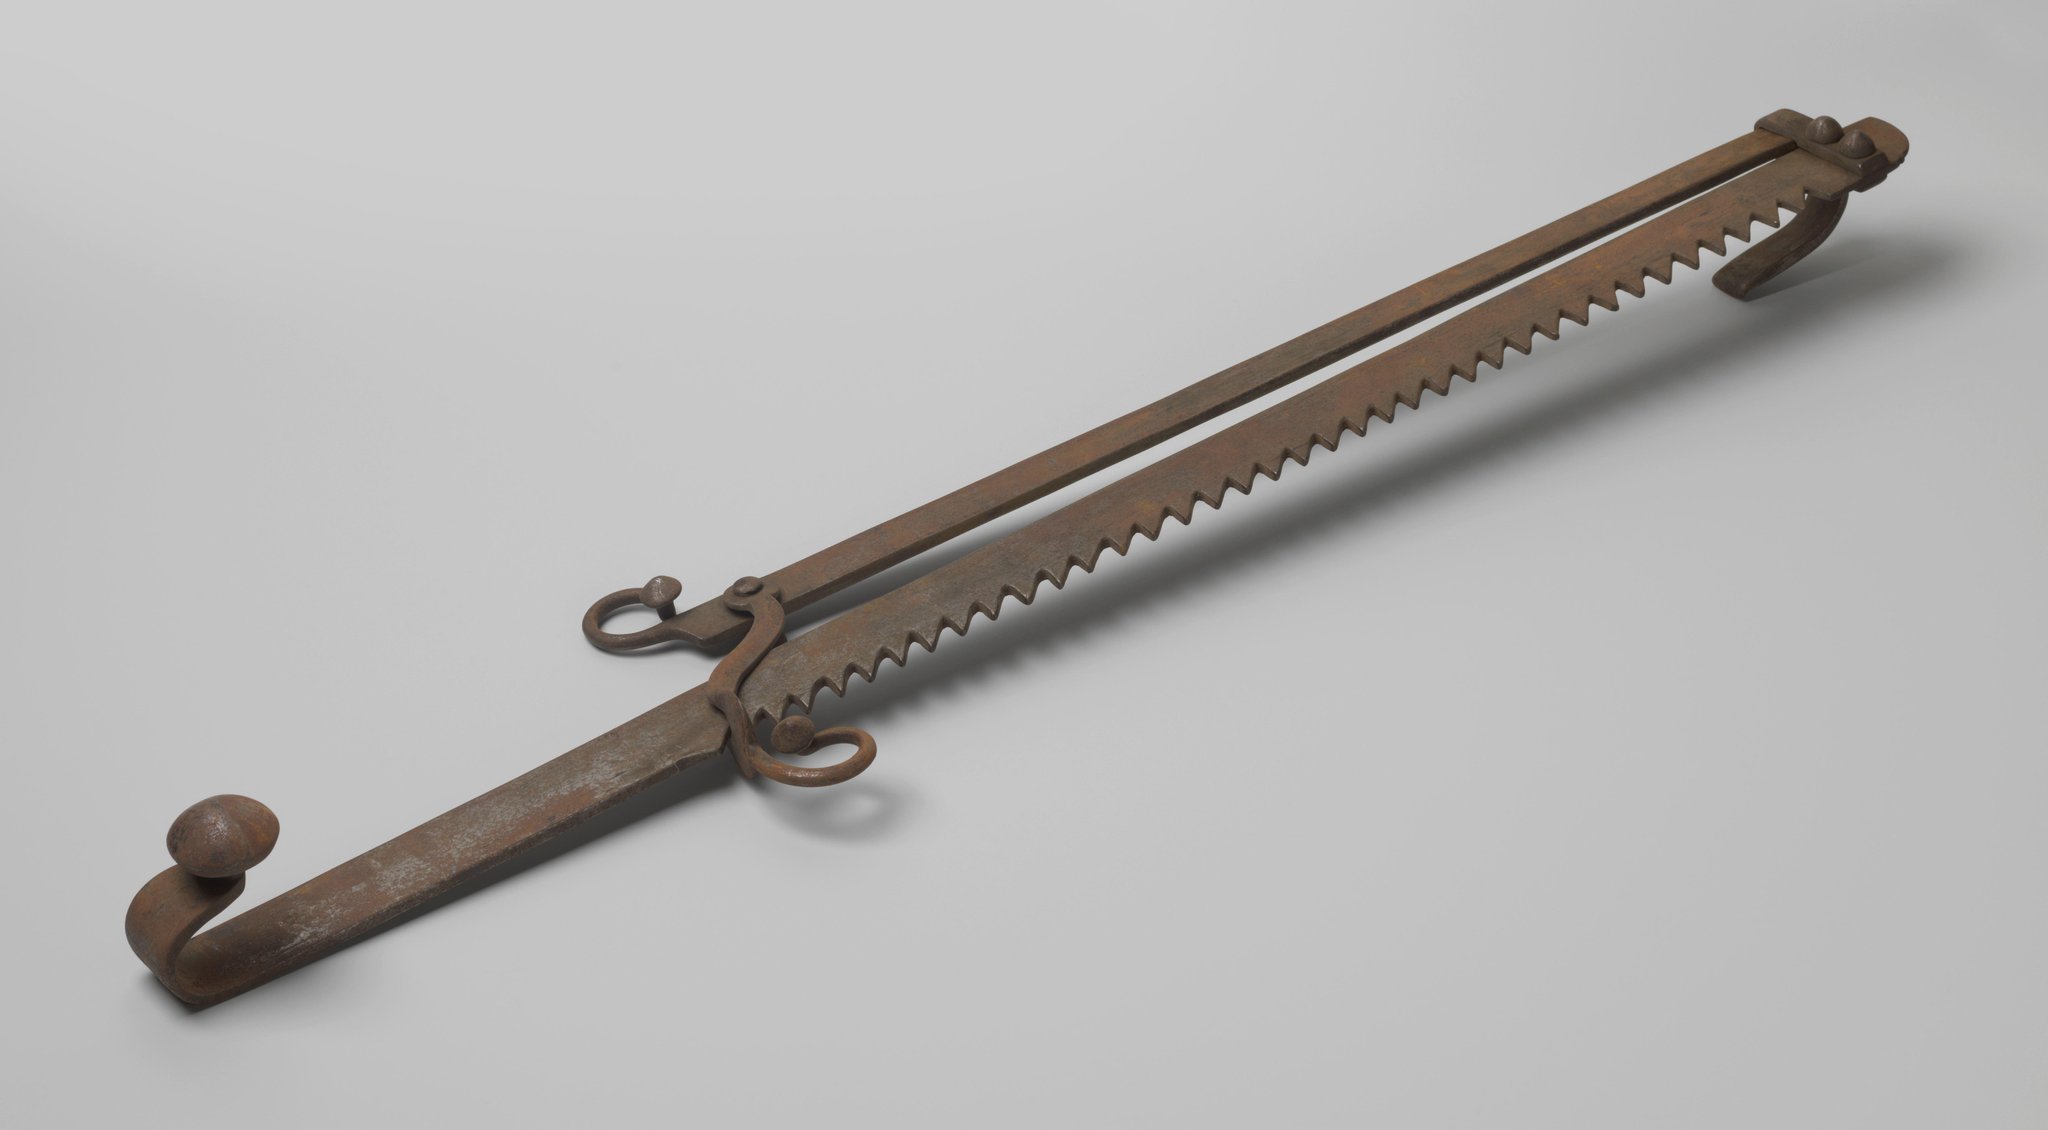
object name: chimney hook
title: Schoorsteenhaak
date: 1600-1699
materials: iron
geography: netherlands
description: Een ijzeren vuurhaak, zonder versiering.